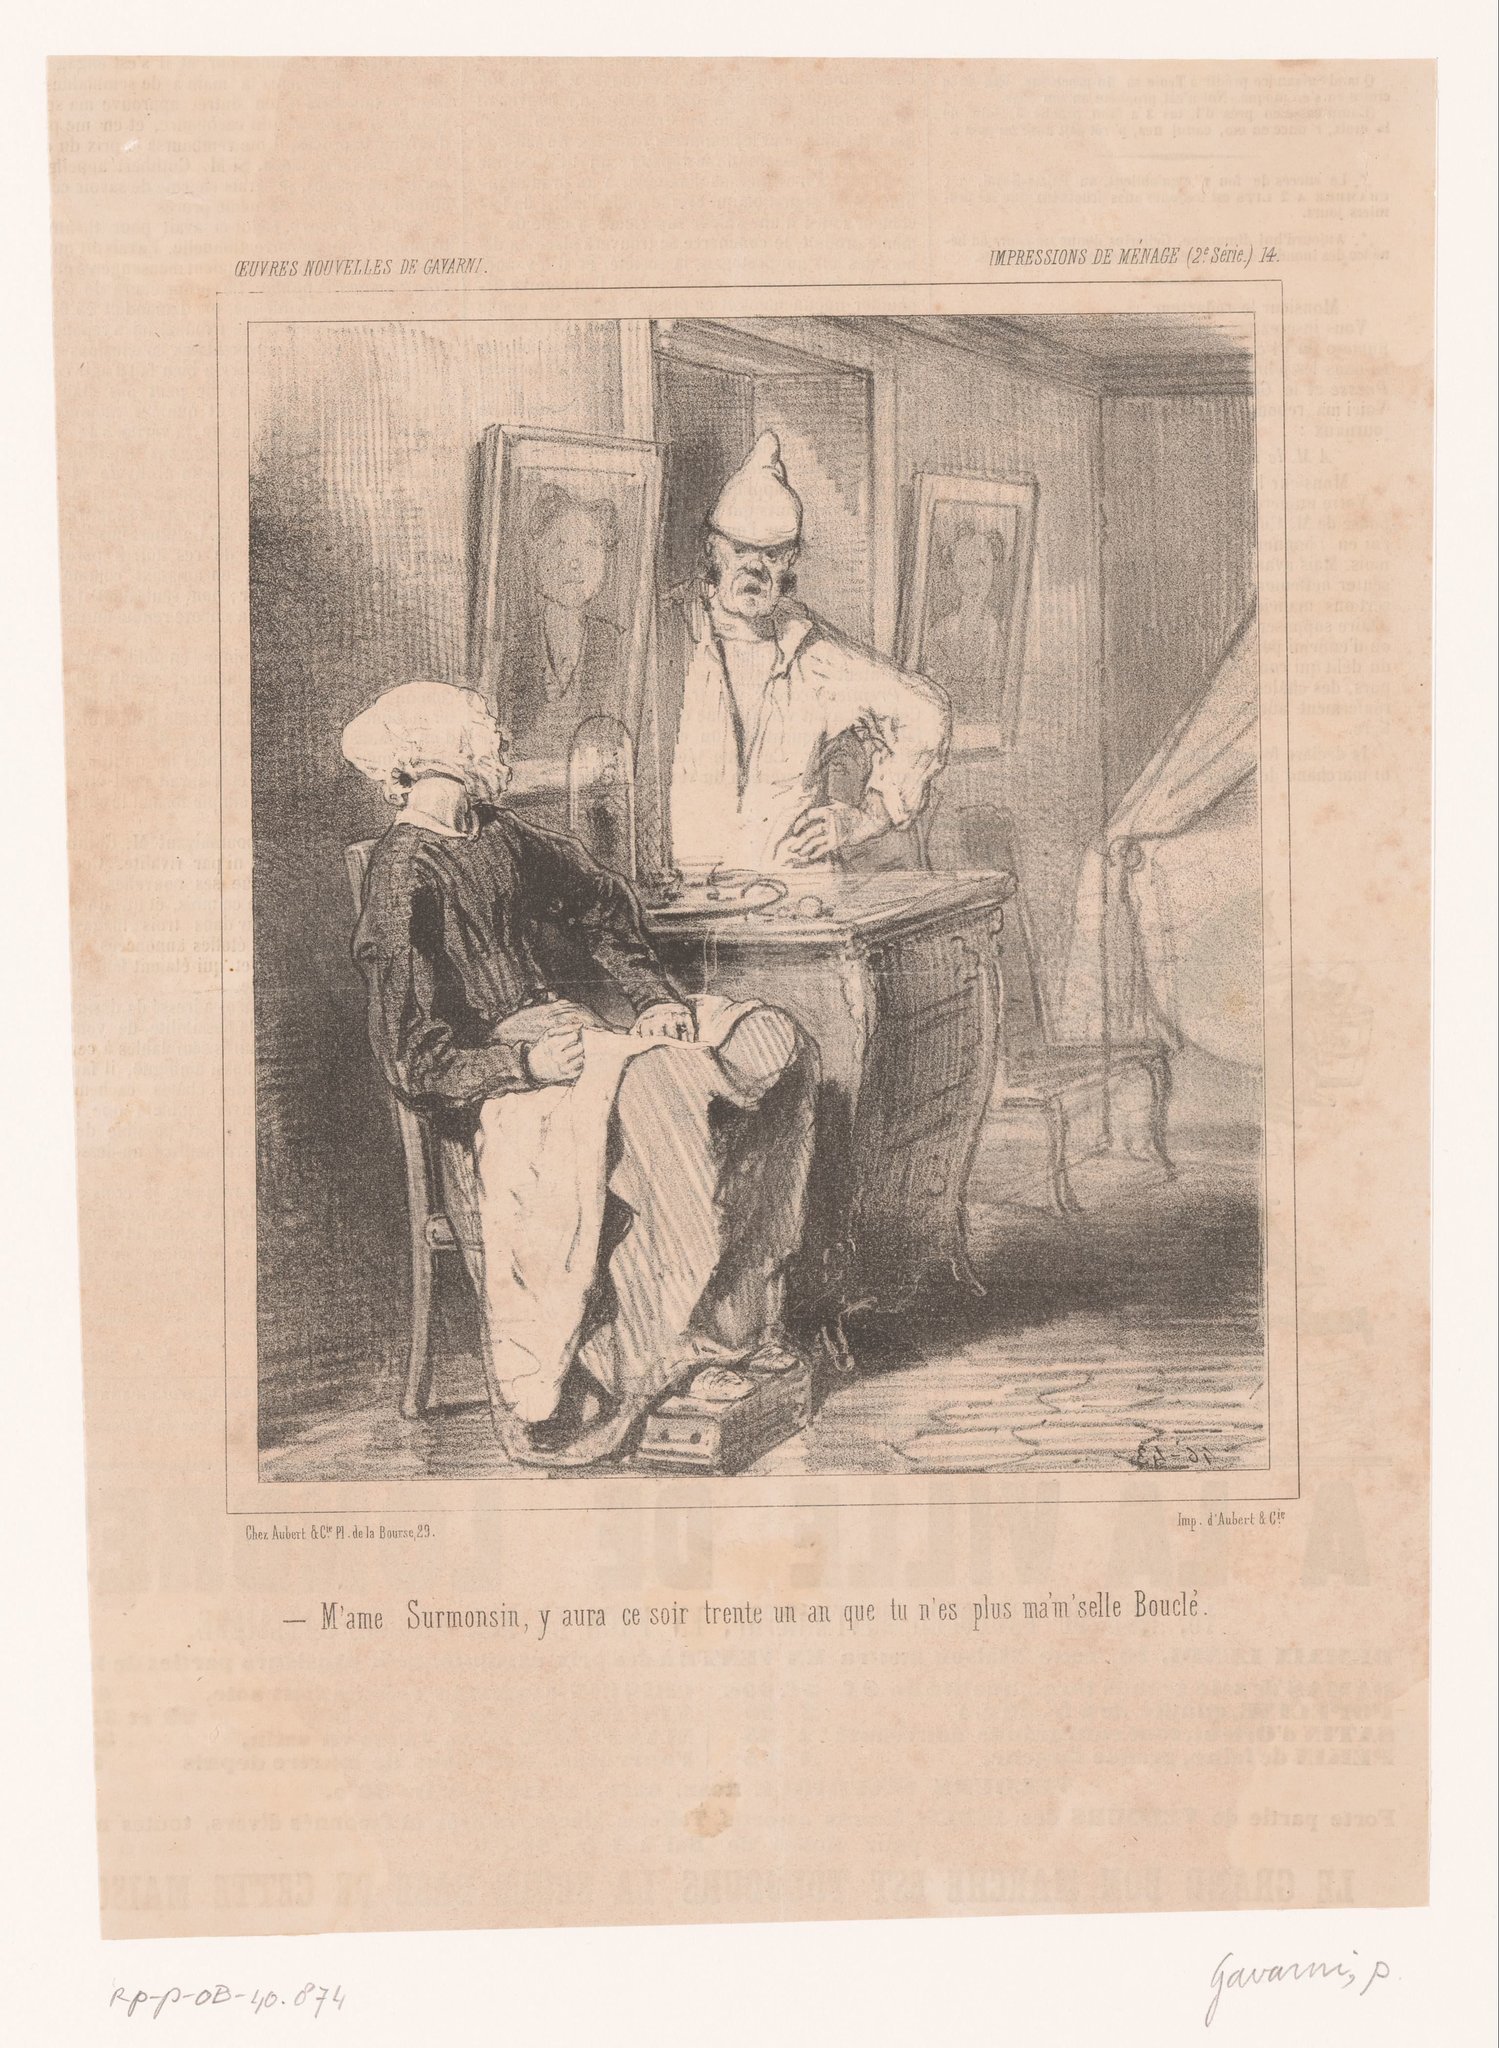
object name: cartoon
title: Impressies van het huwelijk (2)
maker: paul gavarni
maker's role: draughtsman, print maker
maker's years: 1804-1866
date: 1846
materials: paper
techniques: lithograph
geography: paris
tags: old man, old woman, satire on marriage, bedroom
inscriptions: collector's mark: Lugt 2228a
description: De man herinnert zijn vrouw eraan dat het die avond eenendertig jaar geleden is dat ze geen mademoiselle Bouclé meer was, maar madame Surmonsin werd.